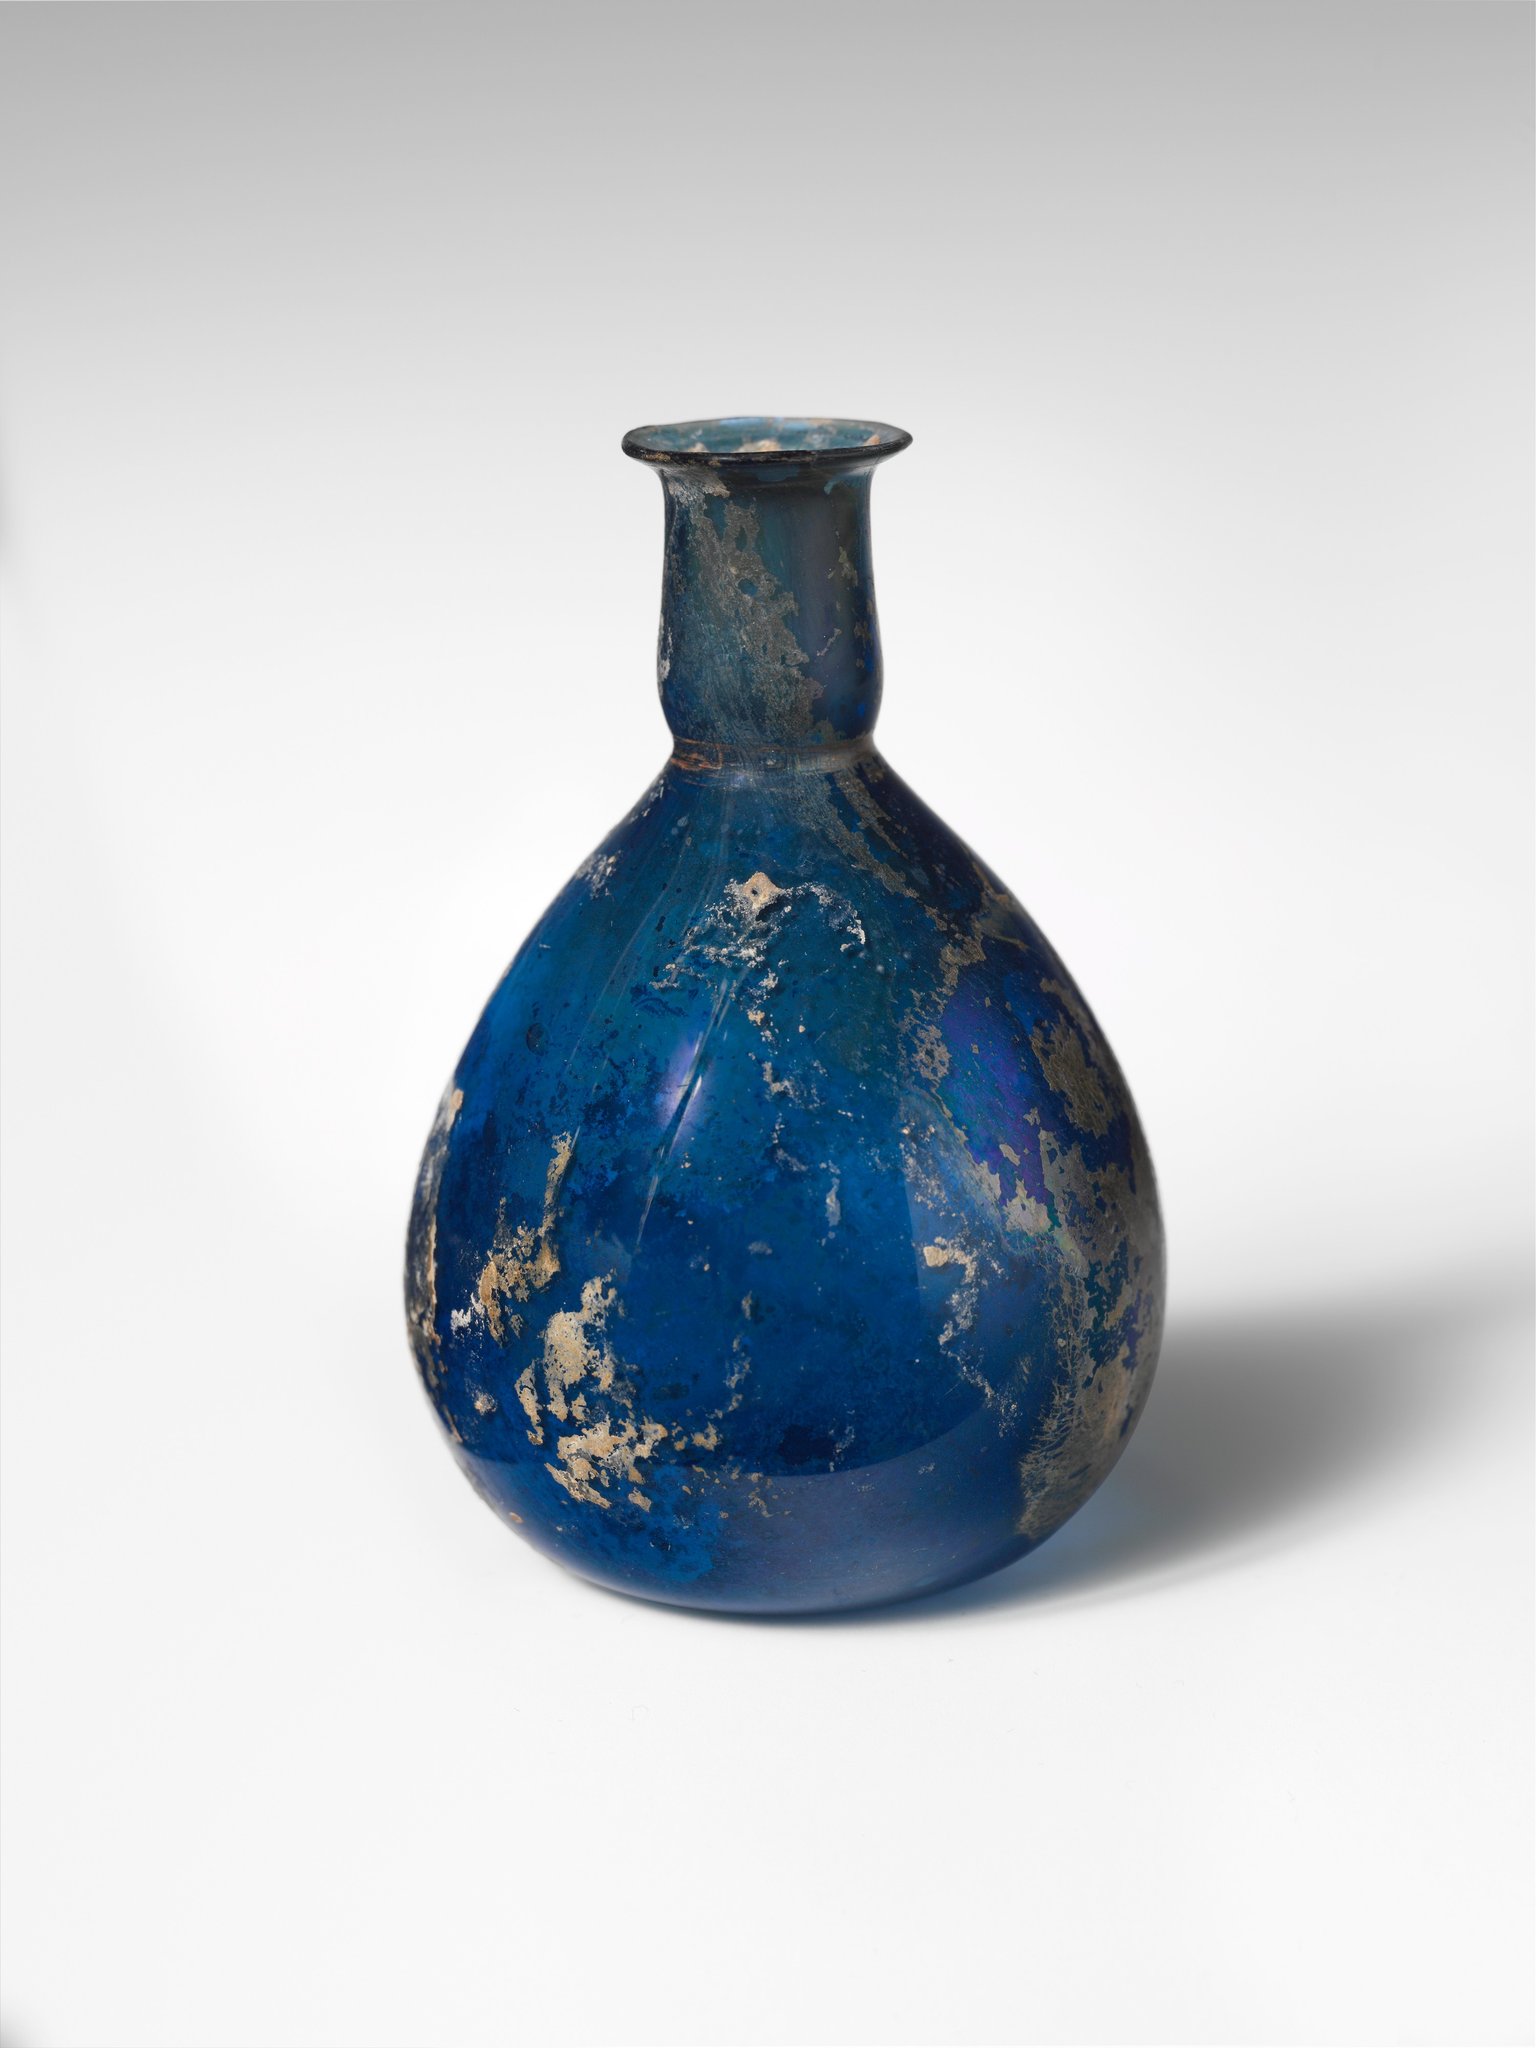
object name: perfume bottle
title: Glass perfume bottle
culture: roman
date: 1-50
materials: glass